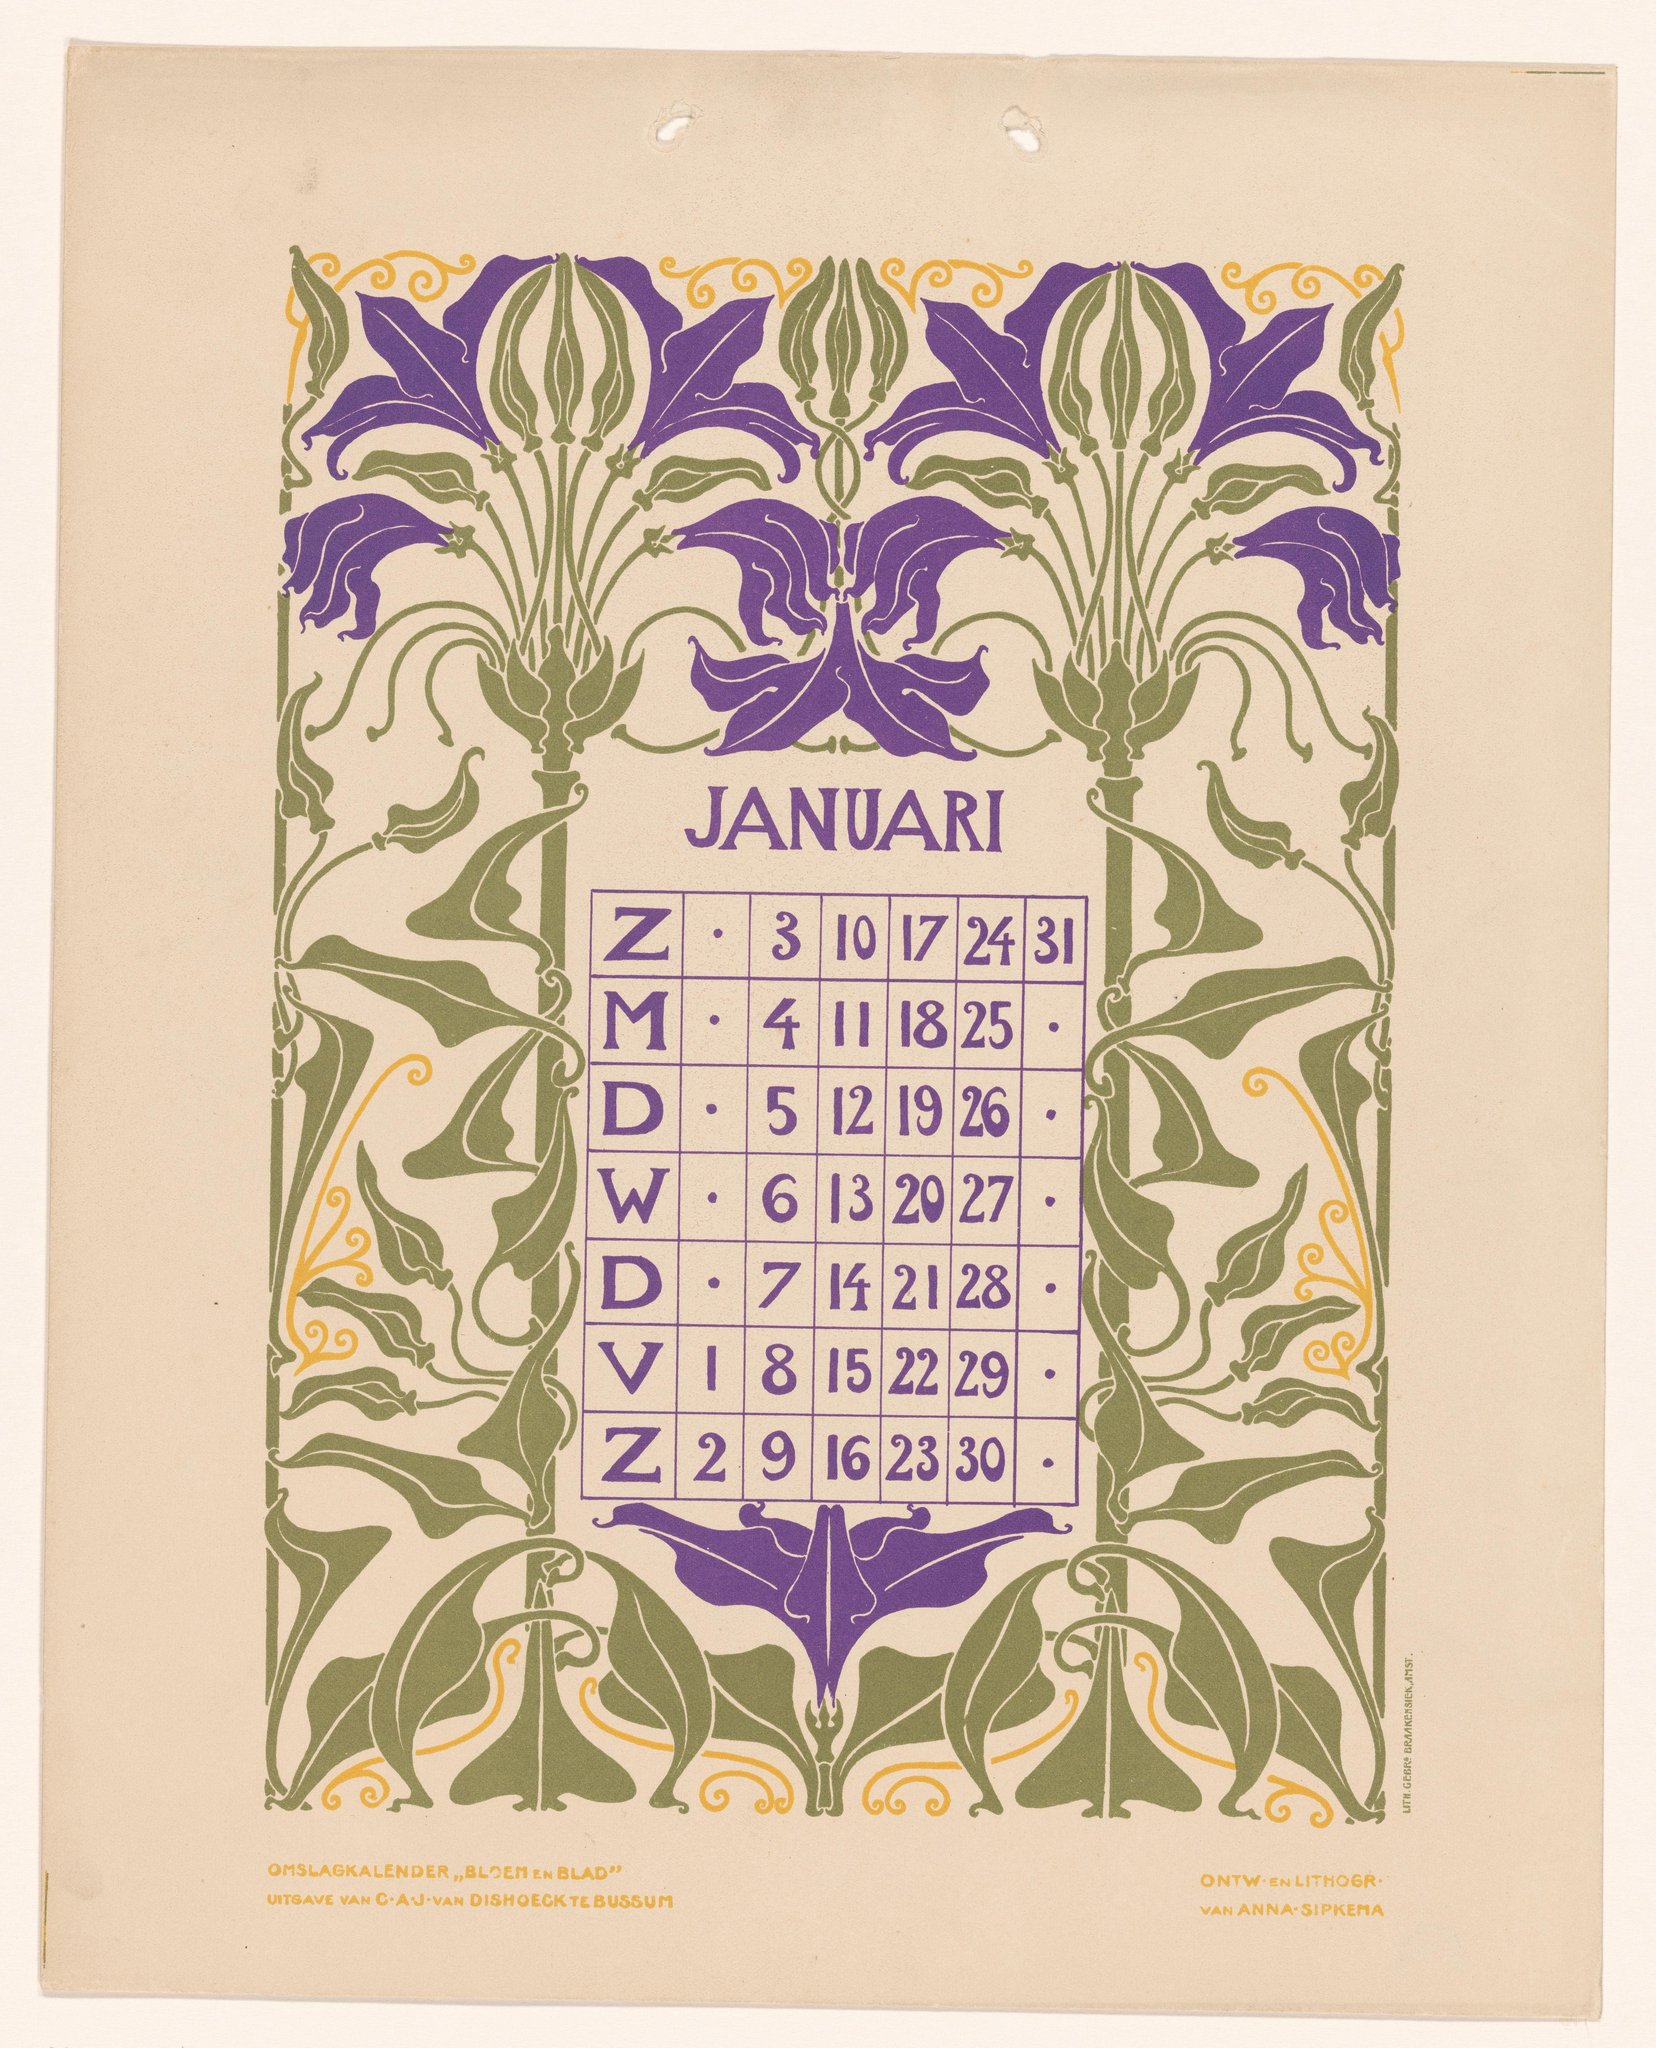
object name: print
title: Omslagkalender "Bloem en blad"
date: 1904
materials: paper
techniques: lithograph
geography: amsterdam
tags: flowers, january ~ other concepts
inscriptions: collector's mark: Lugt 2228